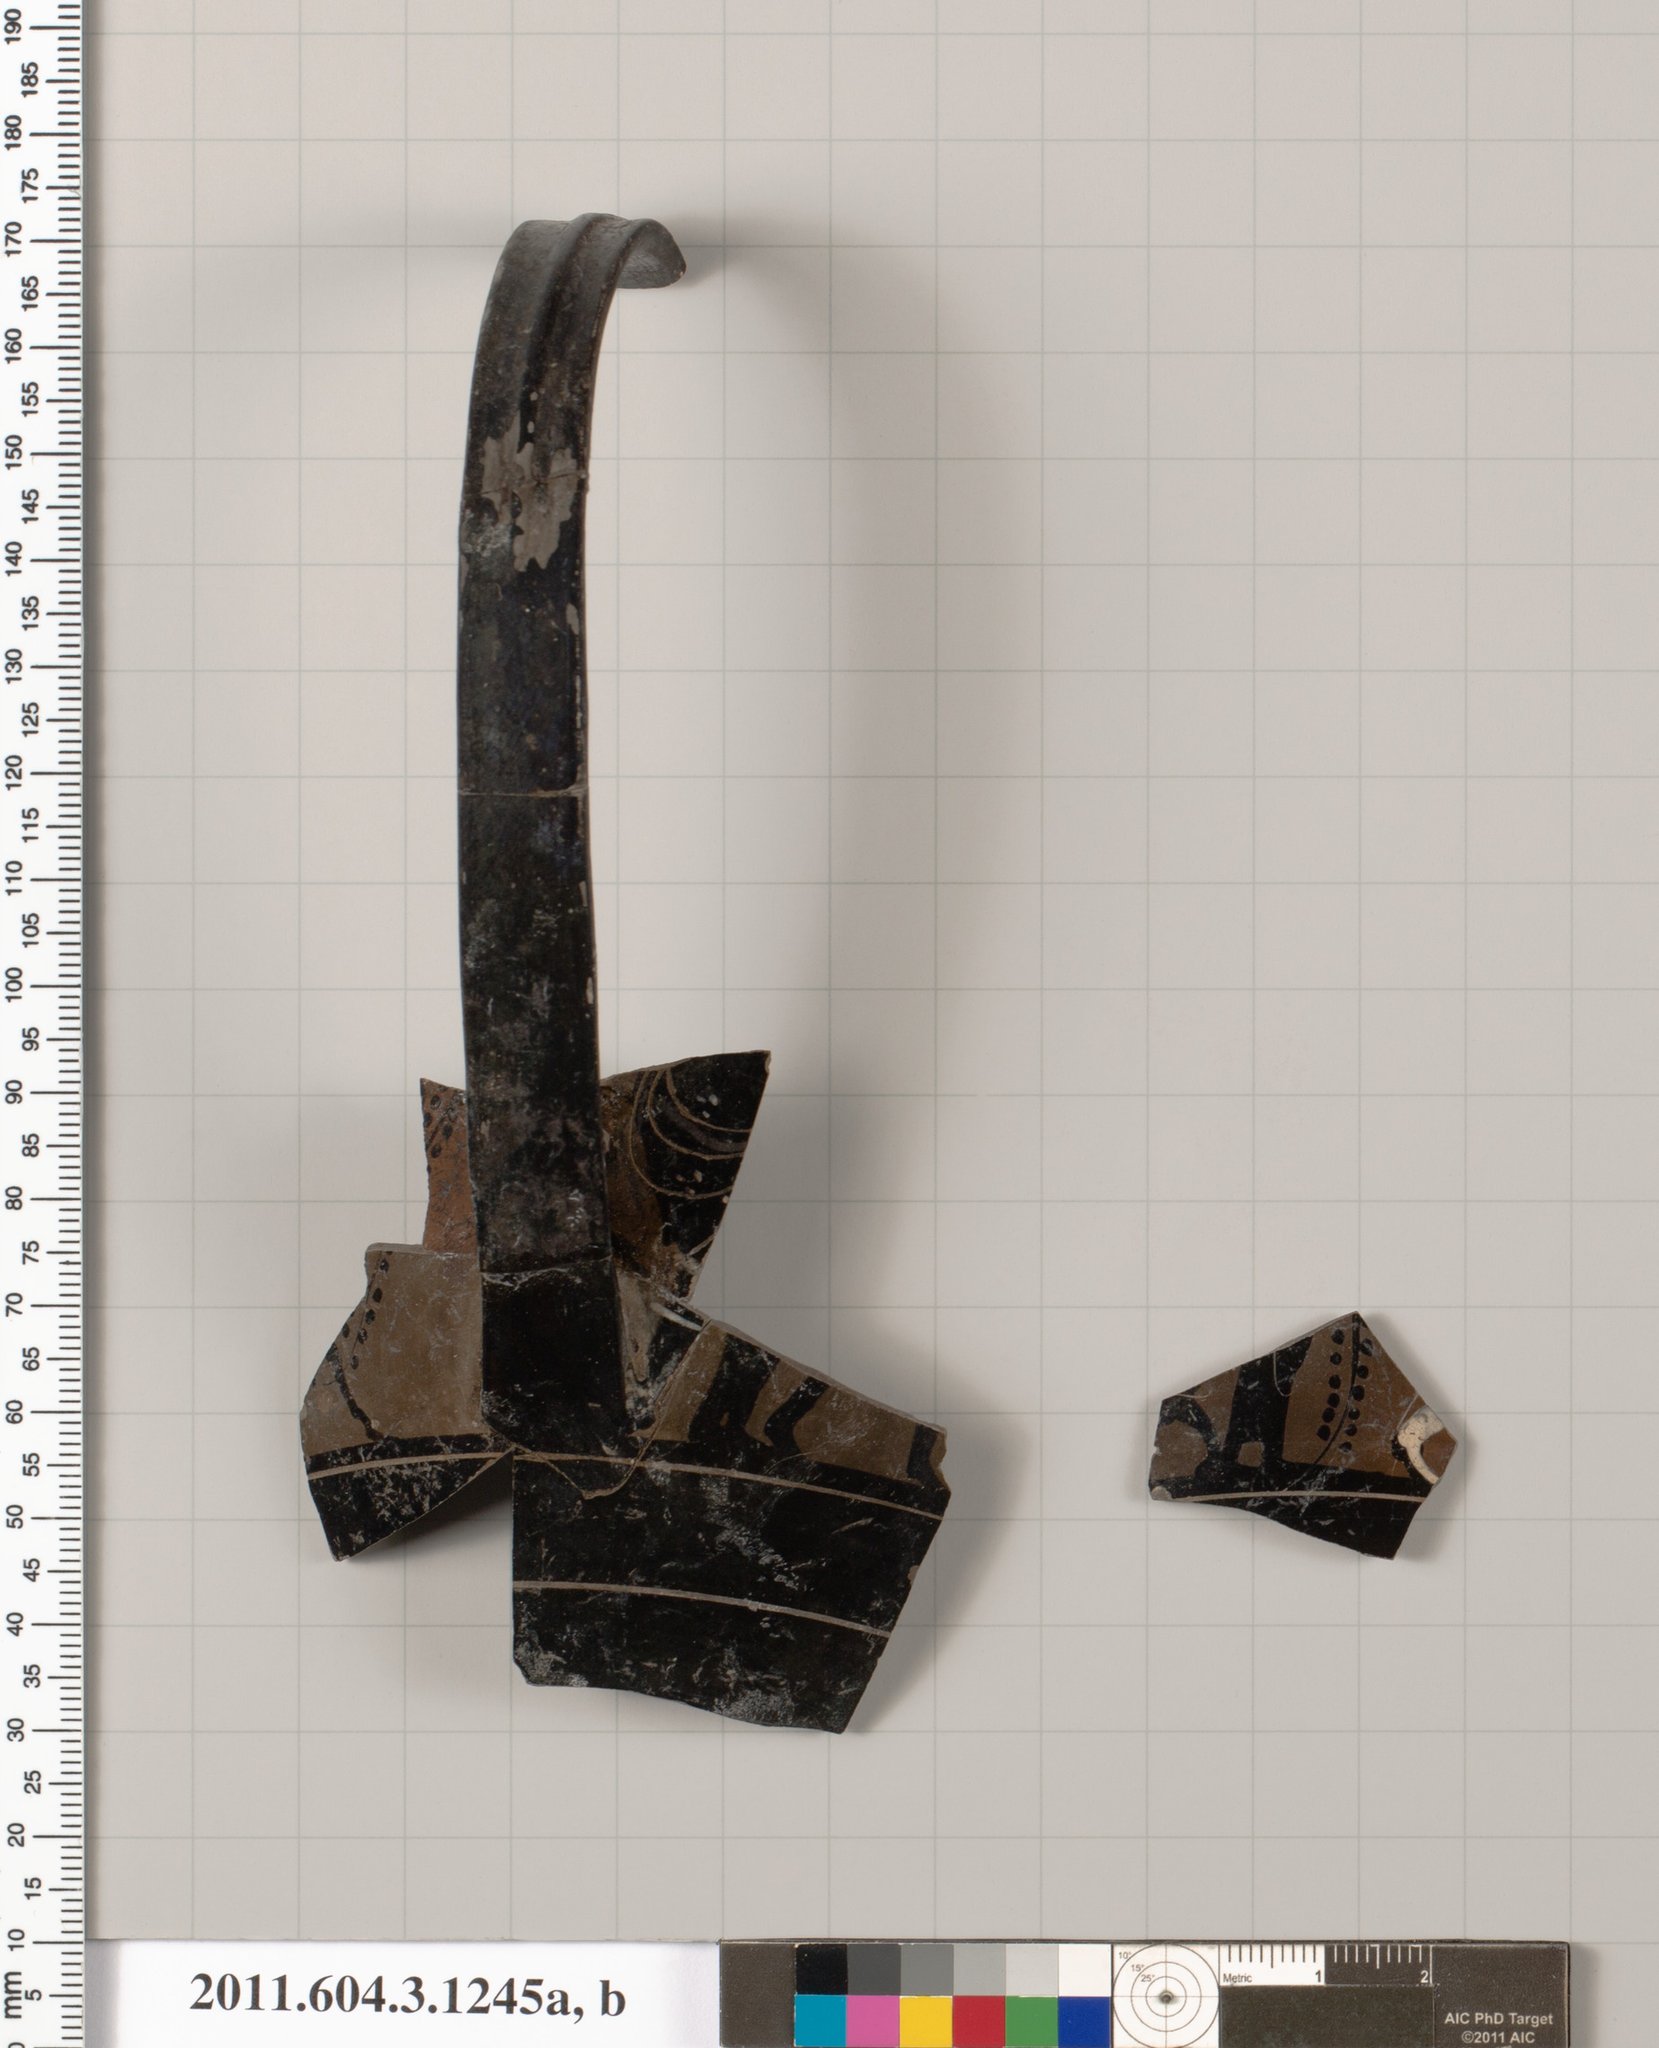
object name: kyathos fragment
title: Terracotta fragments of a kyathos (cup-shaped ladle)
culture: greek, attic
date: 534-468 BCE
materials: terracotta